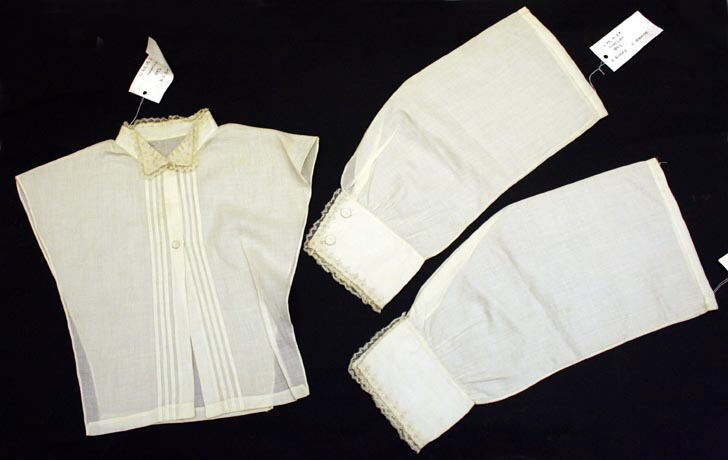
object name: accessory set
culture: american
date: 1893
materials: cotton